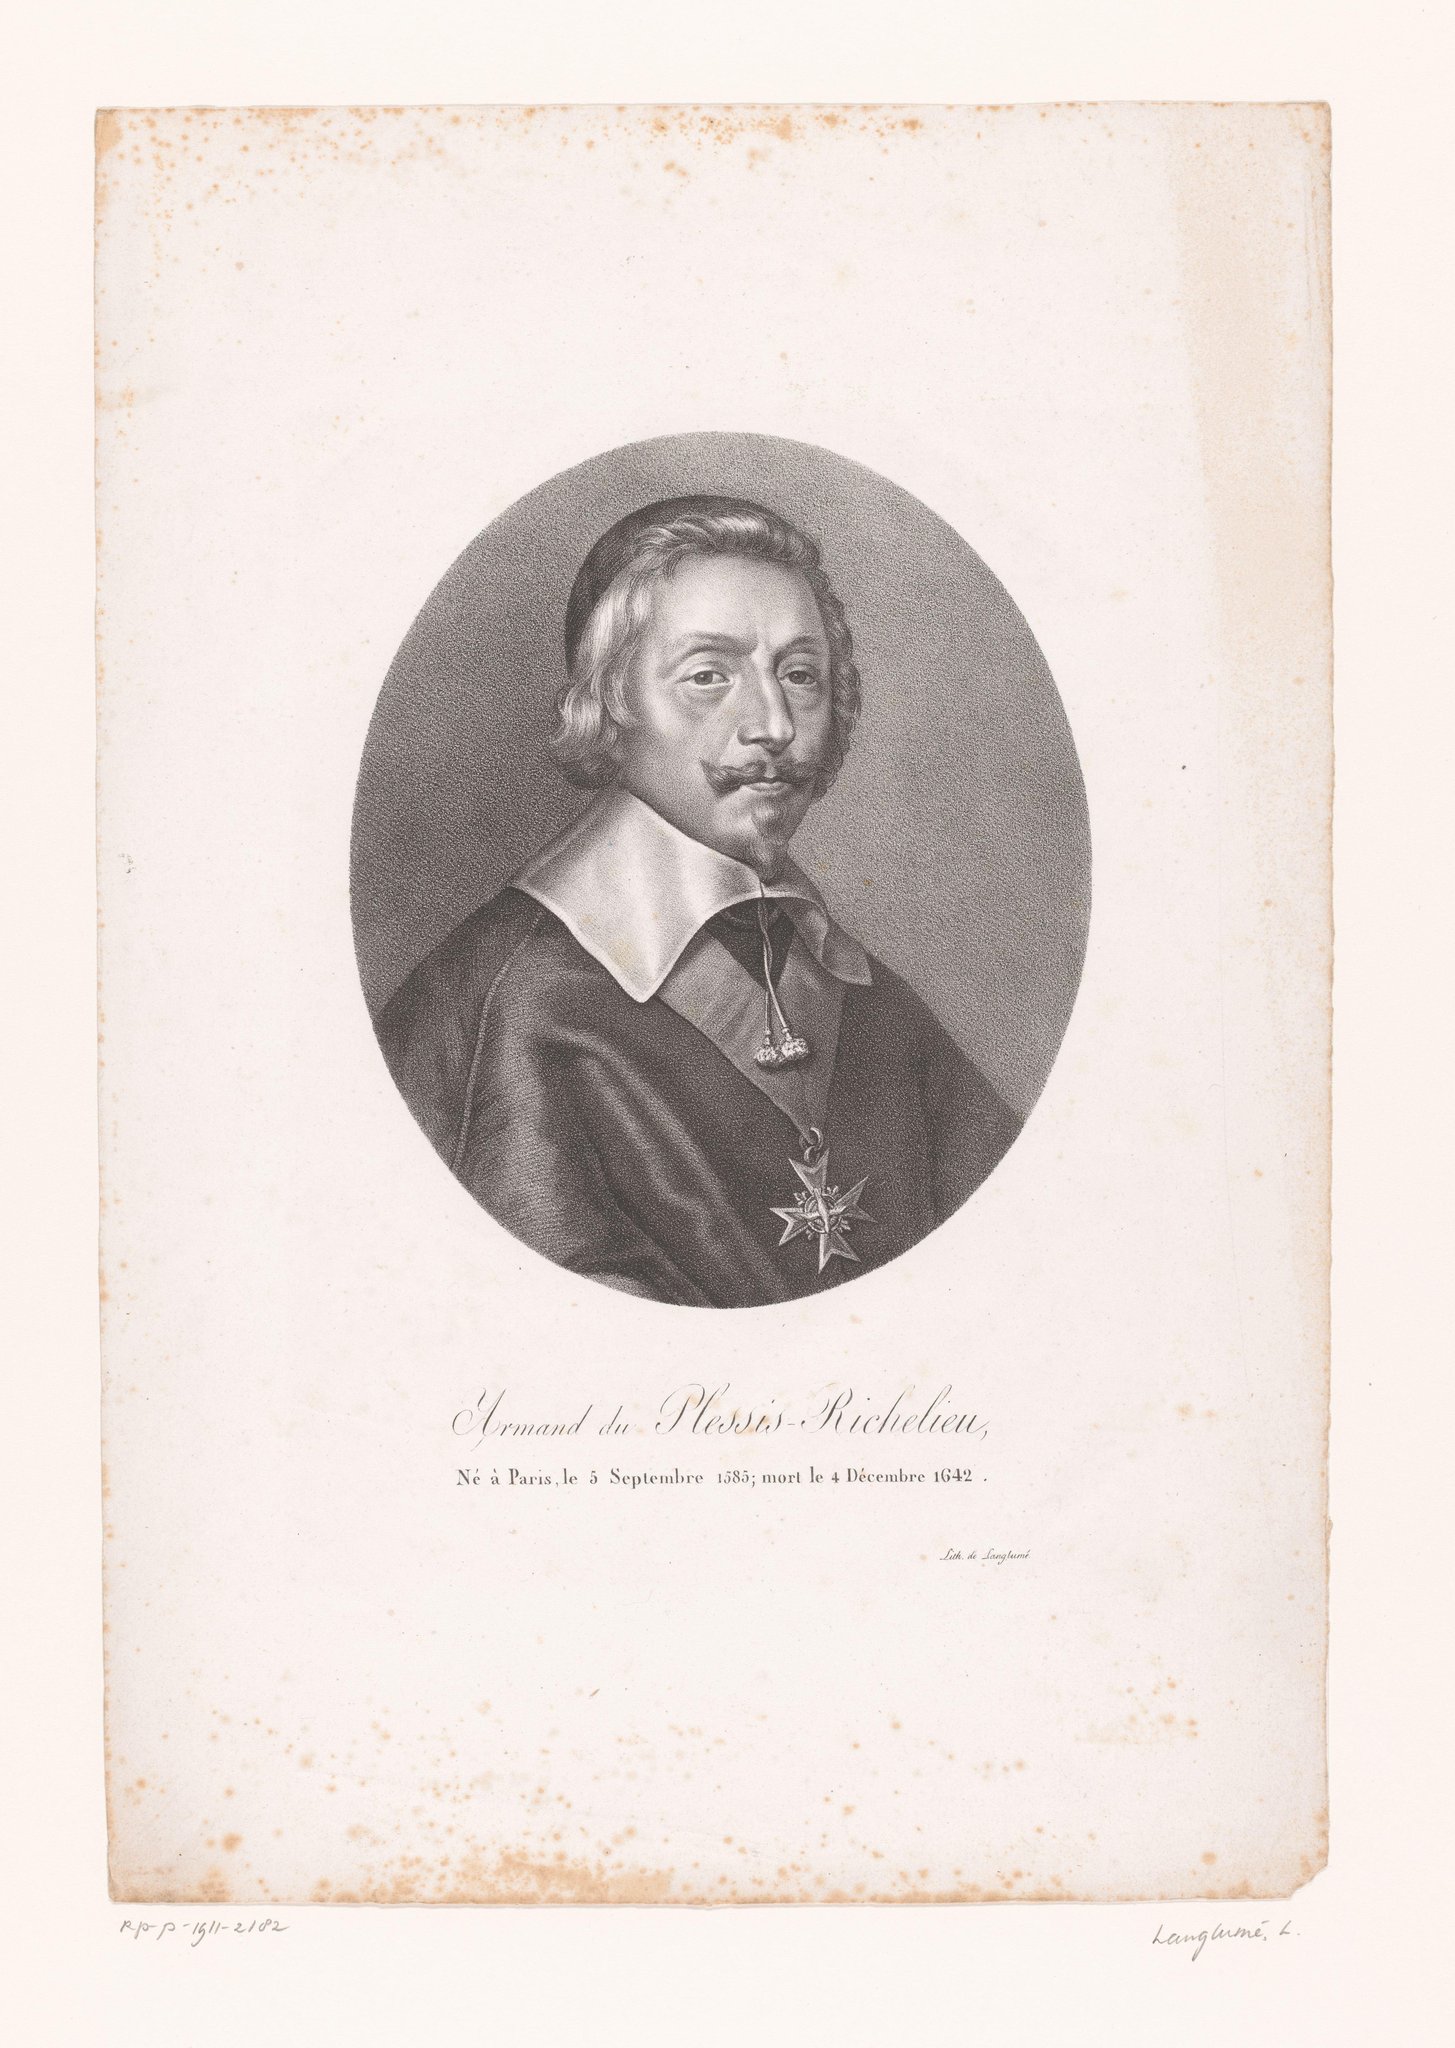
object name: print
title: Armand du Plessis-Richelieu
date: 1820-1830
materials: paper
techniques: lithograph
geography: paris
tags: paris, armand-jean du plessis hertog van richelieu, historical persons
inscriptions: collector's mark: Lugt 2228a